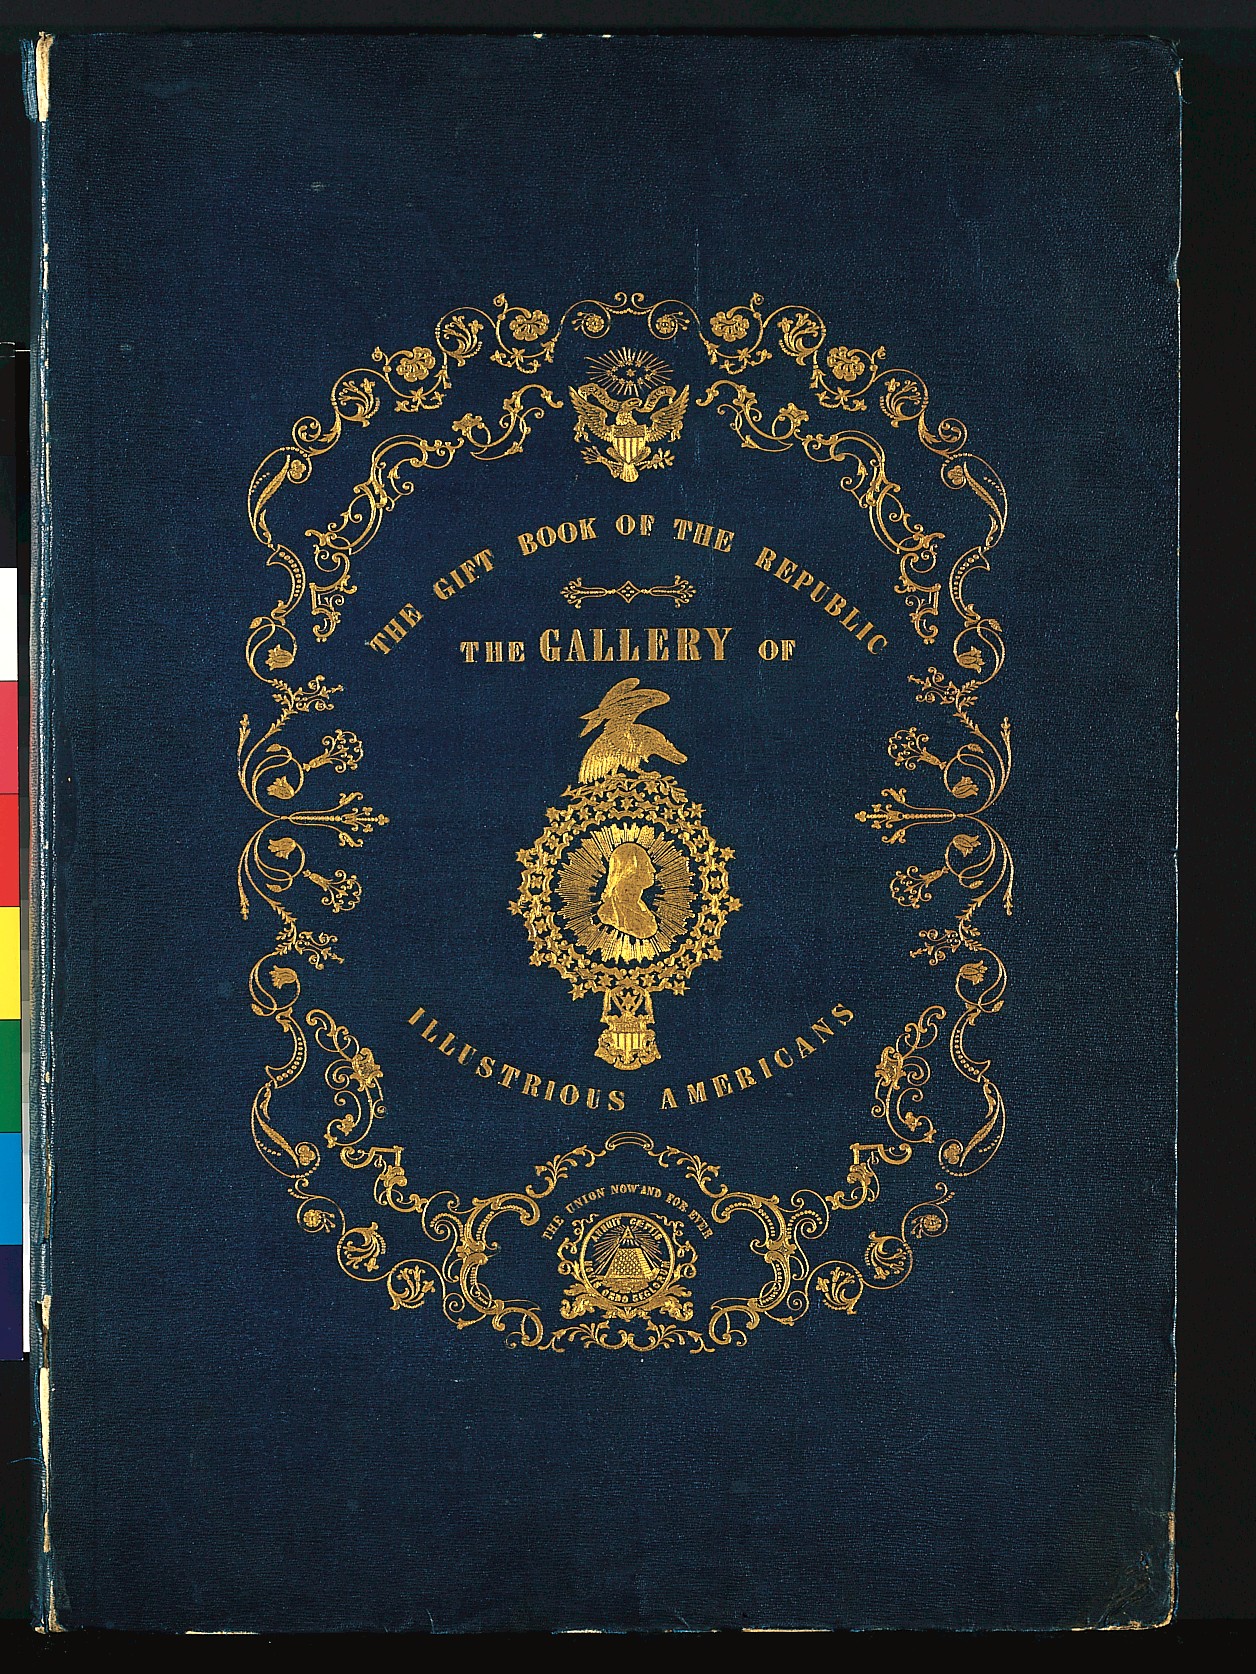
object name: book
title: The Gallery of Illustrious Americans, Containing the Portraits and Biographical Sketches of Twenty-four of the Most Eminent Citizens of the American Republic Since the Death of Washington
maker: brady, d'avignon and company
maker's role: publisher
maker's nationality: american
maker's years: 1800-1900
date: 1850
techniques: lithograph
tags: men,portraits